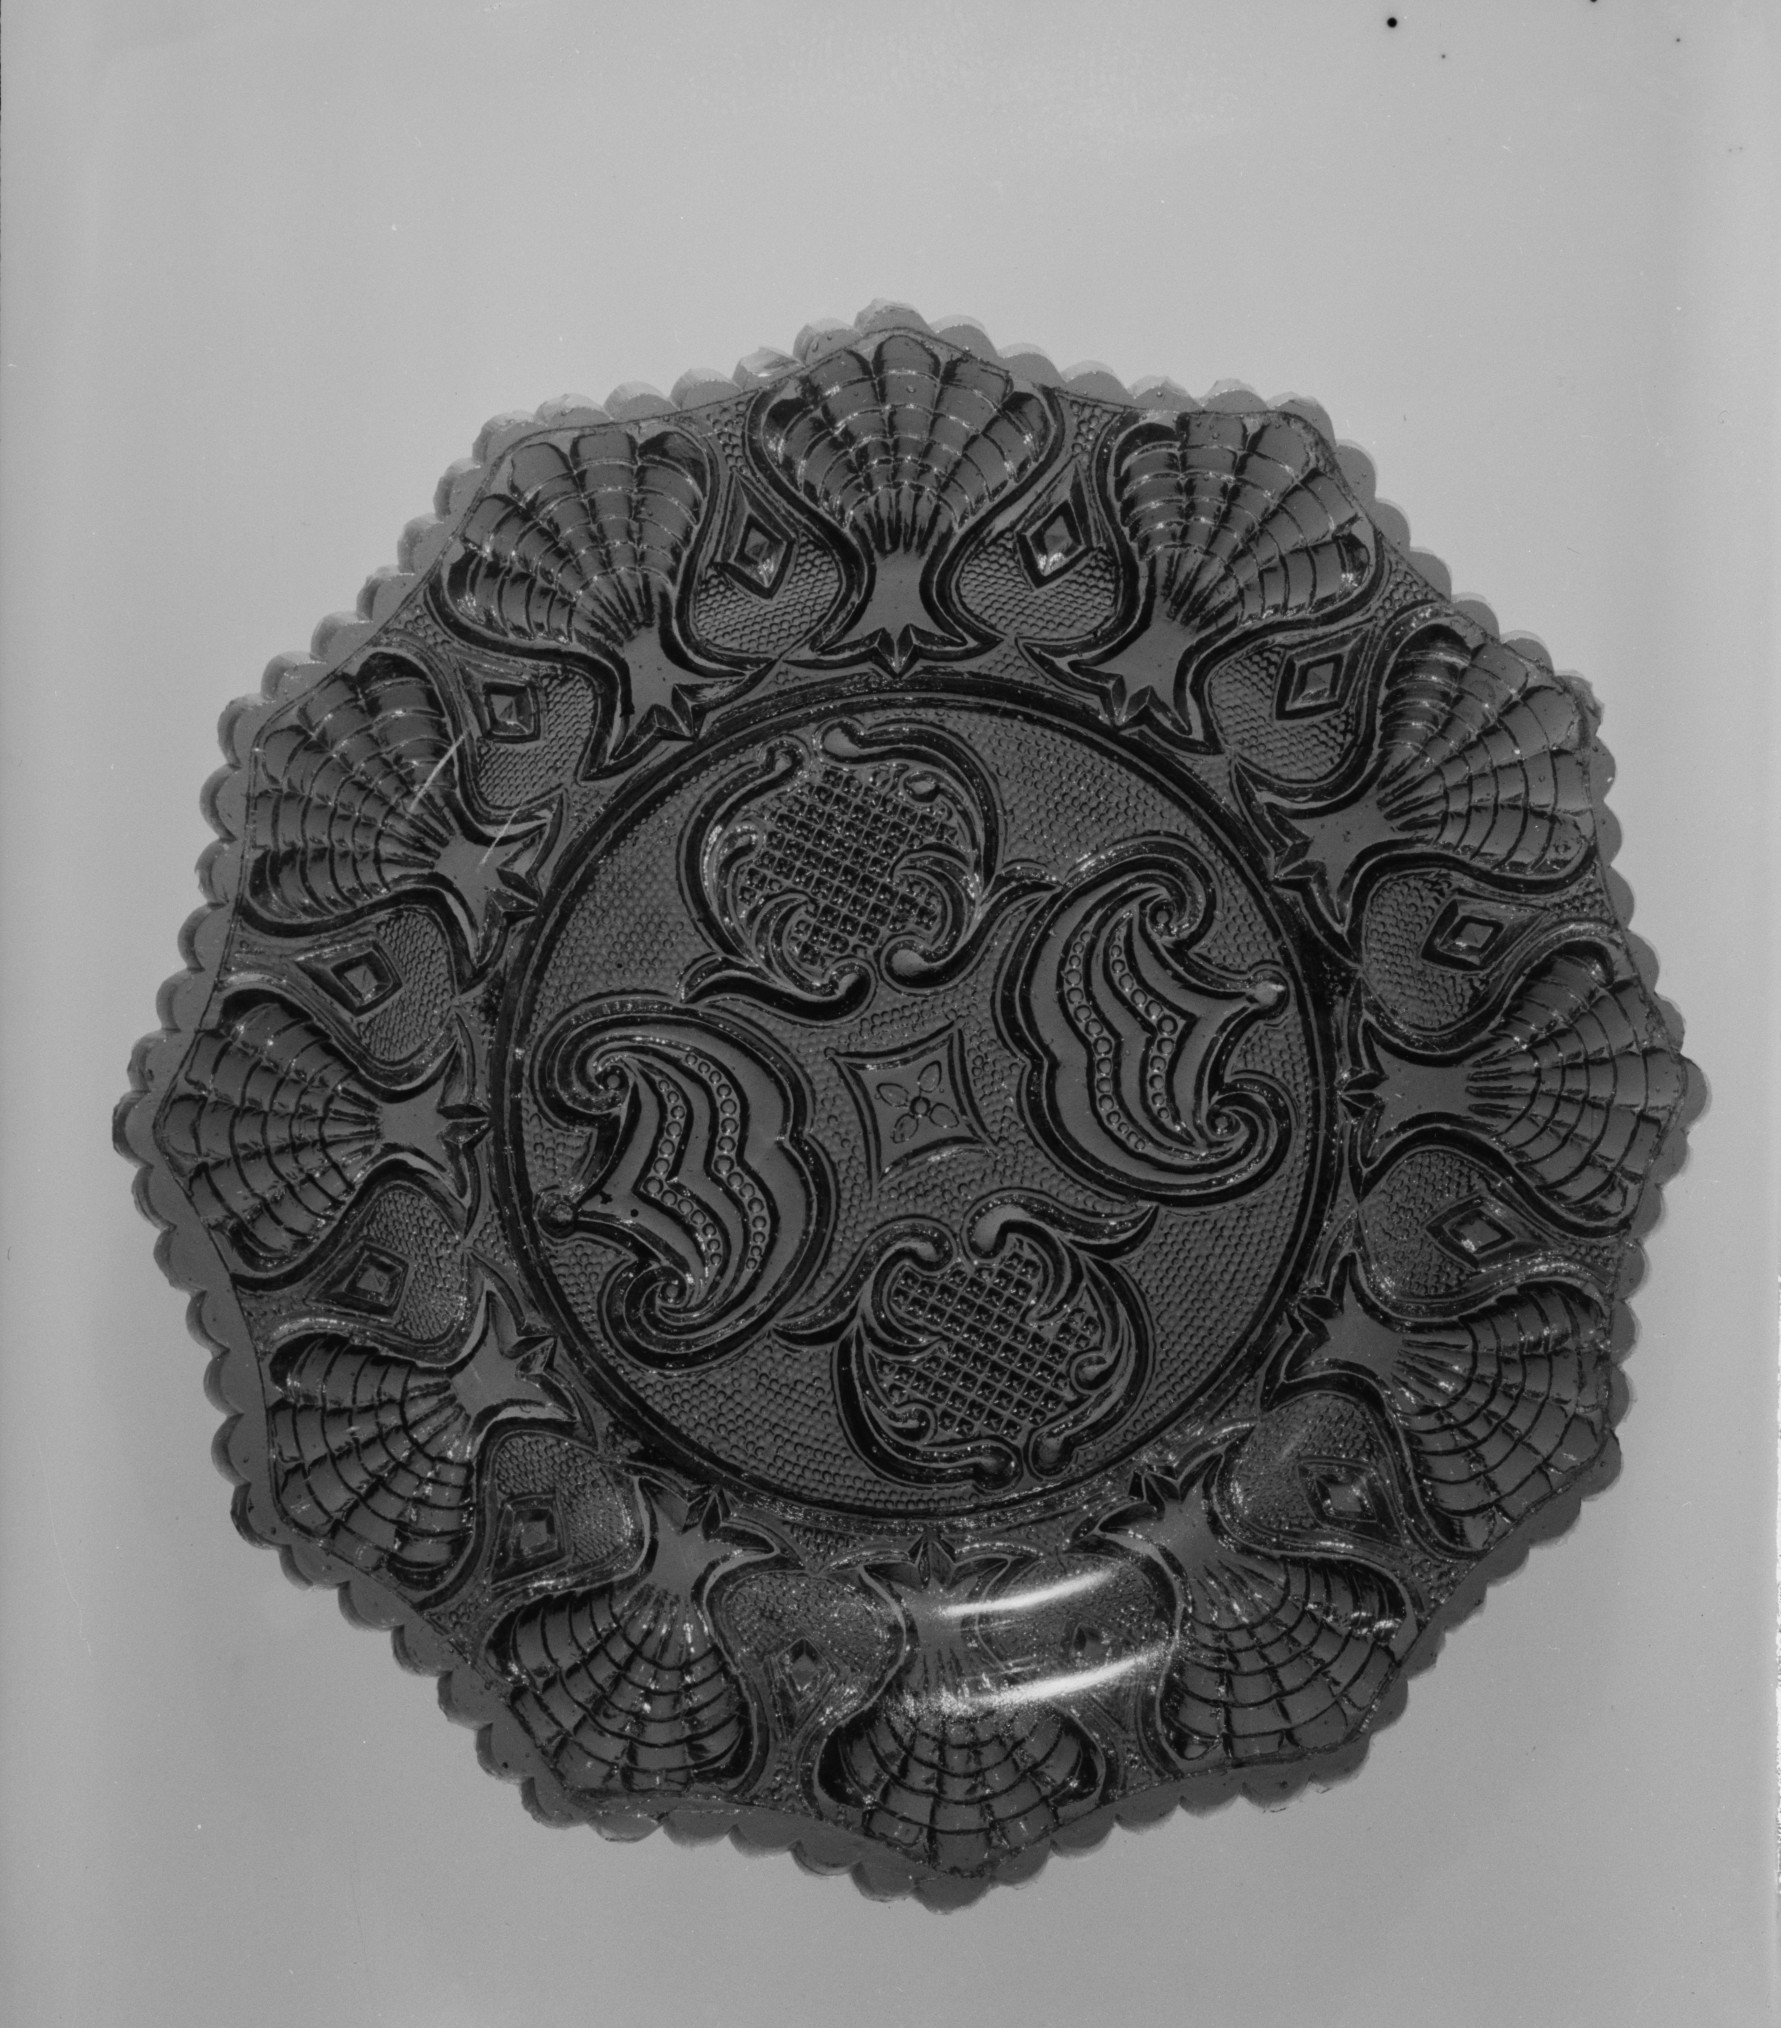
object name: plate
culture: american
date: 1830-1840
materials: glass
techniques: pressed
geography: united states